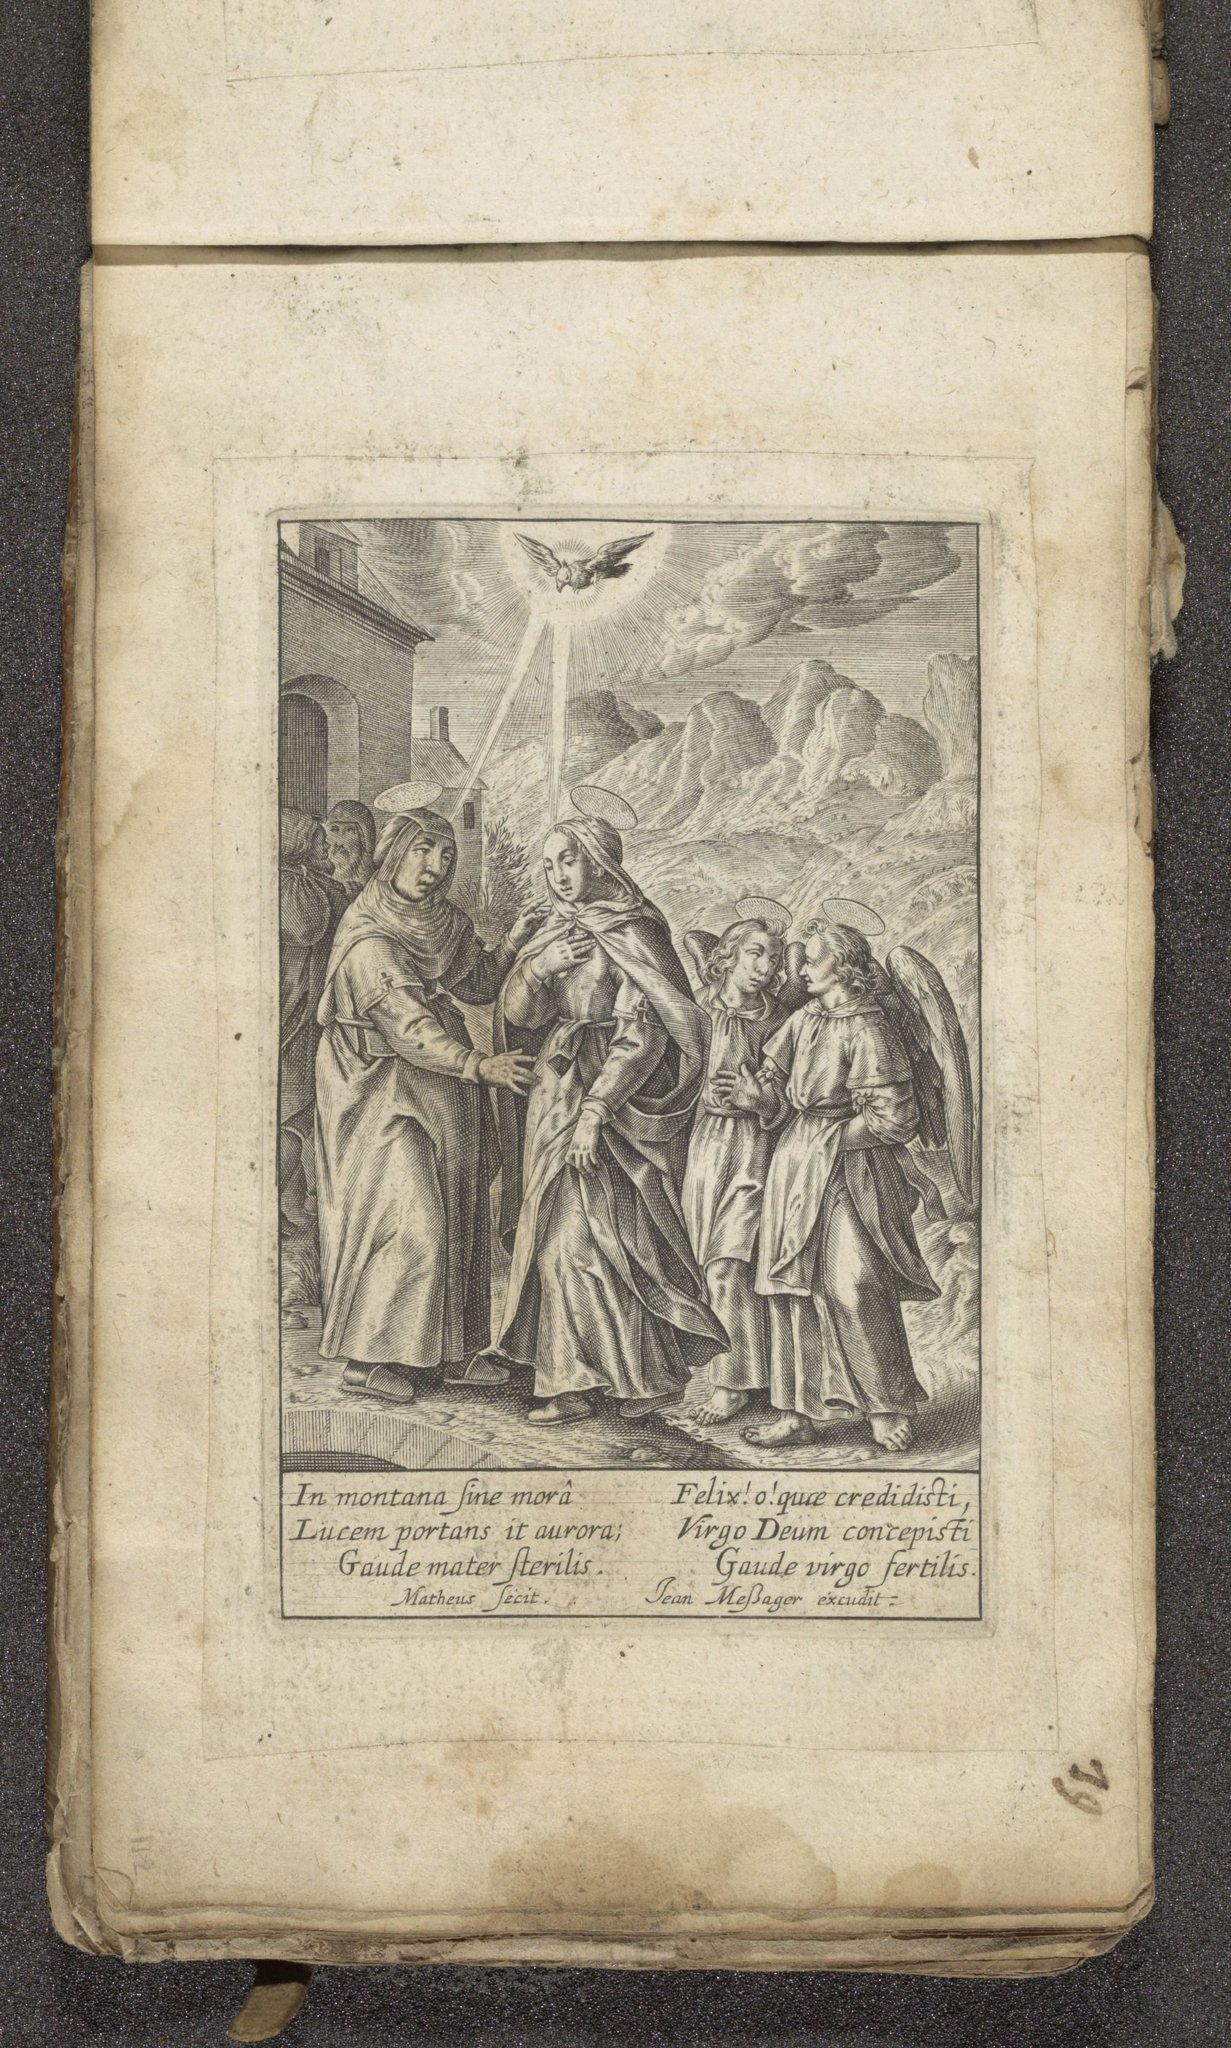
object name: album leaf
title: Leven van de maagd Maria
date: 1590-1649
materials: paper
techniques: engraving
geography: paris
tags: visitation (possibly joseph and/or zacharias present) (luke 1:39-56) (+ angel(s)), holy ghost represented as a dove (in flames)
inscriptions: inscription: ‘79’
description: Maria bezoekt haar nicht Elisabet. Ze wordt gevolgd door twee engelen. Op de achtergrond in de deuropening Zacharias en Jozef. Vanuit de hemel daalt de duif van de Heilige Geest neer op de zwangere Maria en Elisabet. In de marge een zesregelig onderschrift, in twee kolommen, in het Latijn. De prent maakt deel uit van een album.